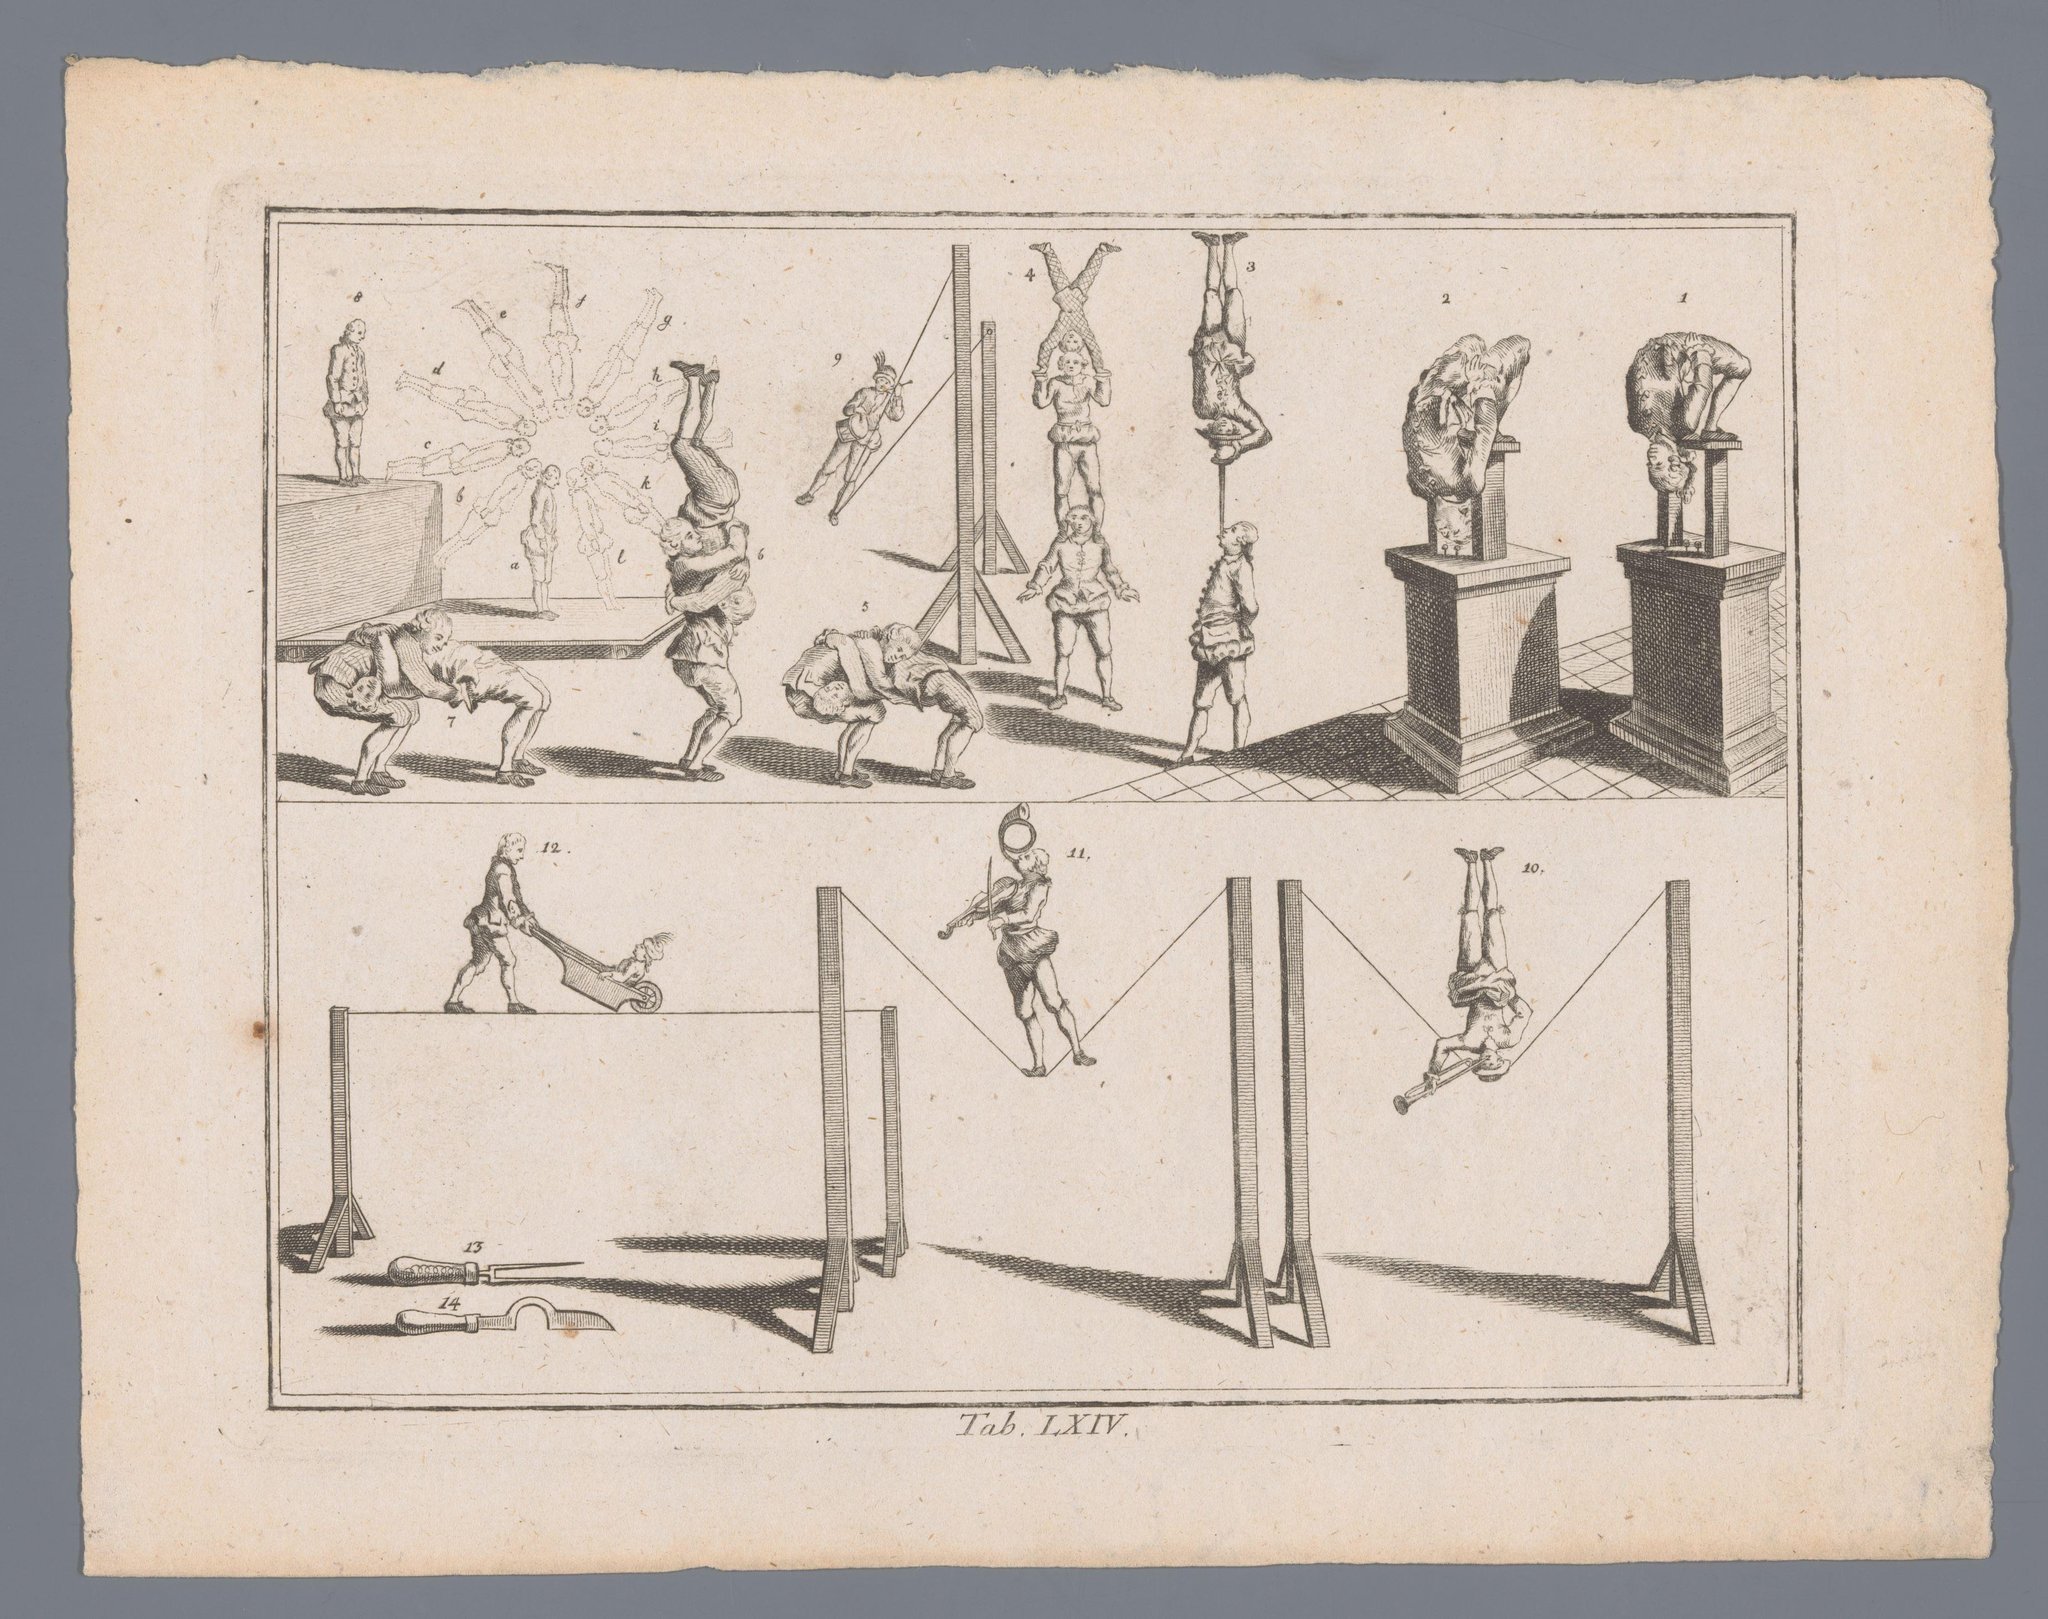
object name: print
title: Acrobatische trucs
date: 1774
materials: paper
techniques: etching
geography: germany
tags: equilibrist, contortionist, acrobat ~ circus, tight-ropewalker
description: Prent ook gebruikt in: Basedow, Johann Bernhard. Das Basedowische Elementarwerk. Ein Vorrath der besten Erkenntnisse zum Lernen, Lehren, Wiederholen und Nachdenken. Leipzig: Siegfried Lebrecht Crucius, 1774.